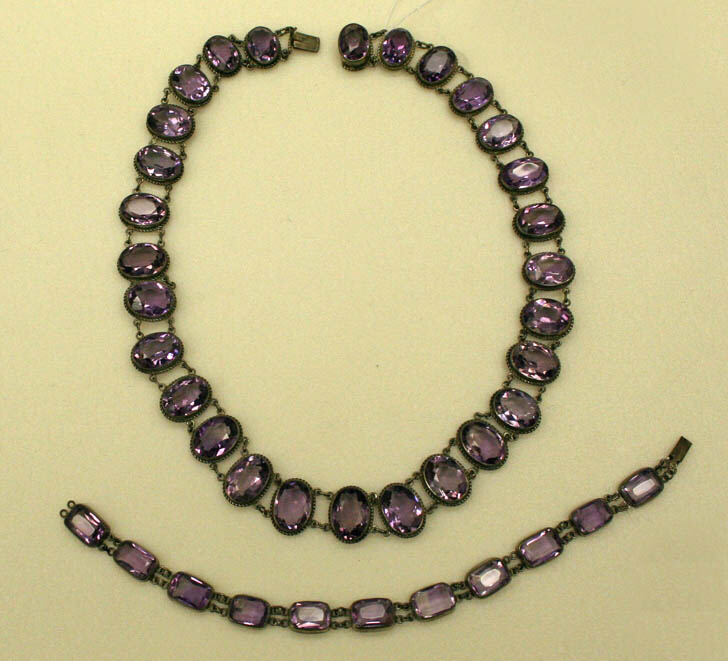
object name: jewelry set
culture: american or european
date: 1850-1899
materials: gemstone, silver, stone